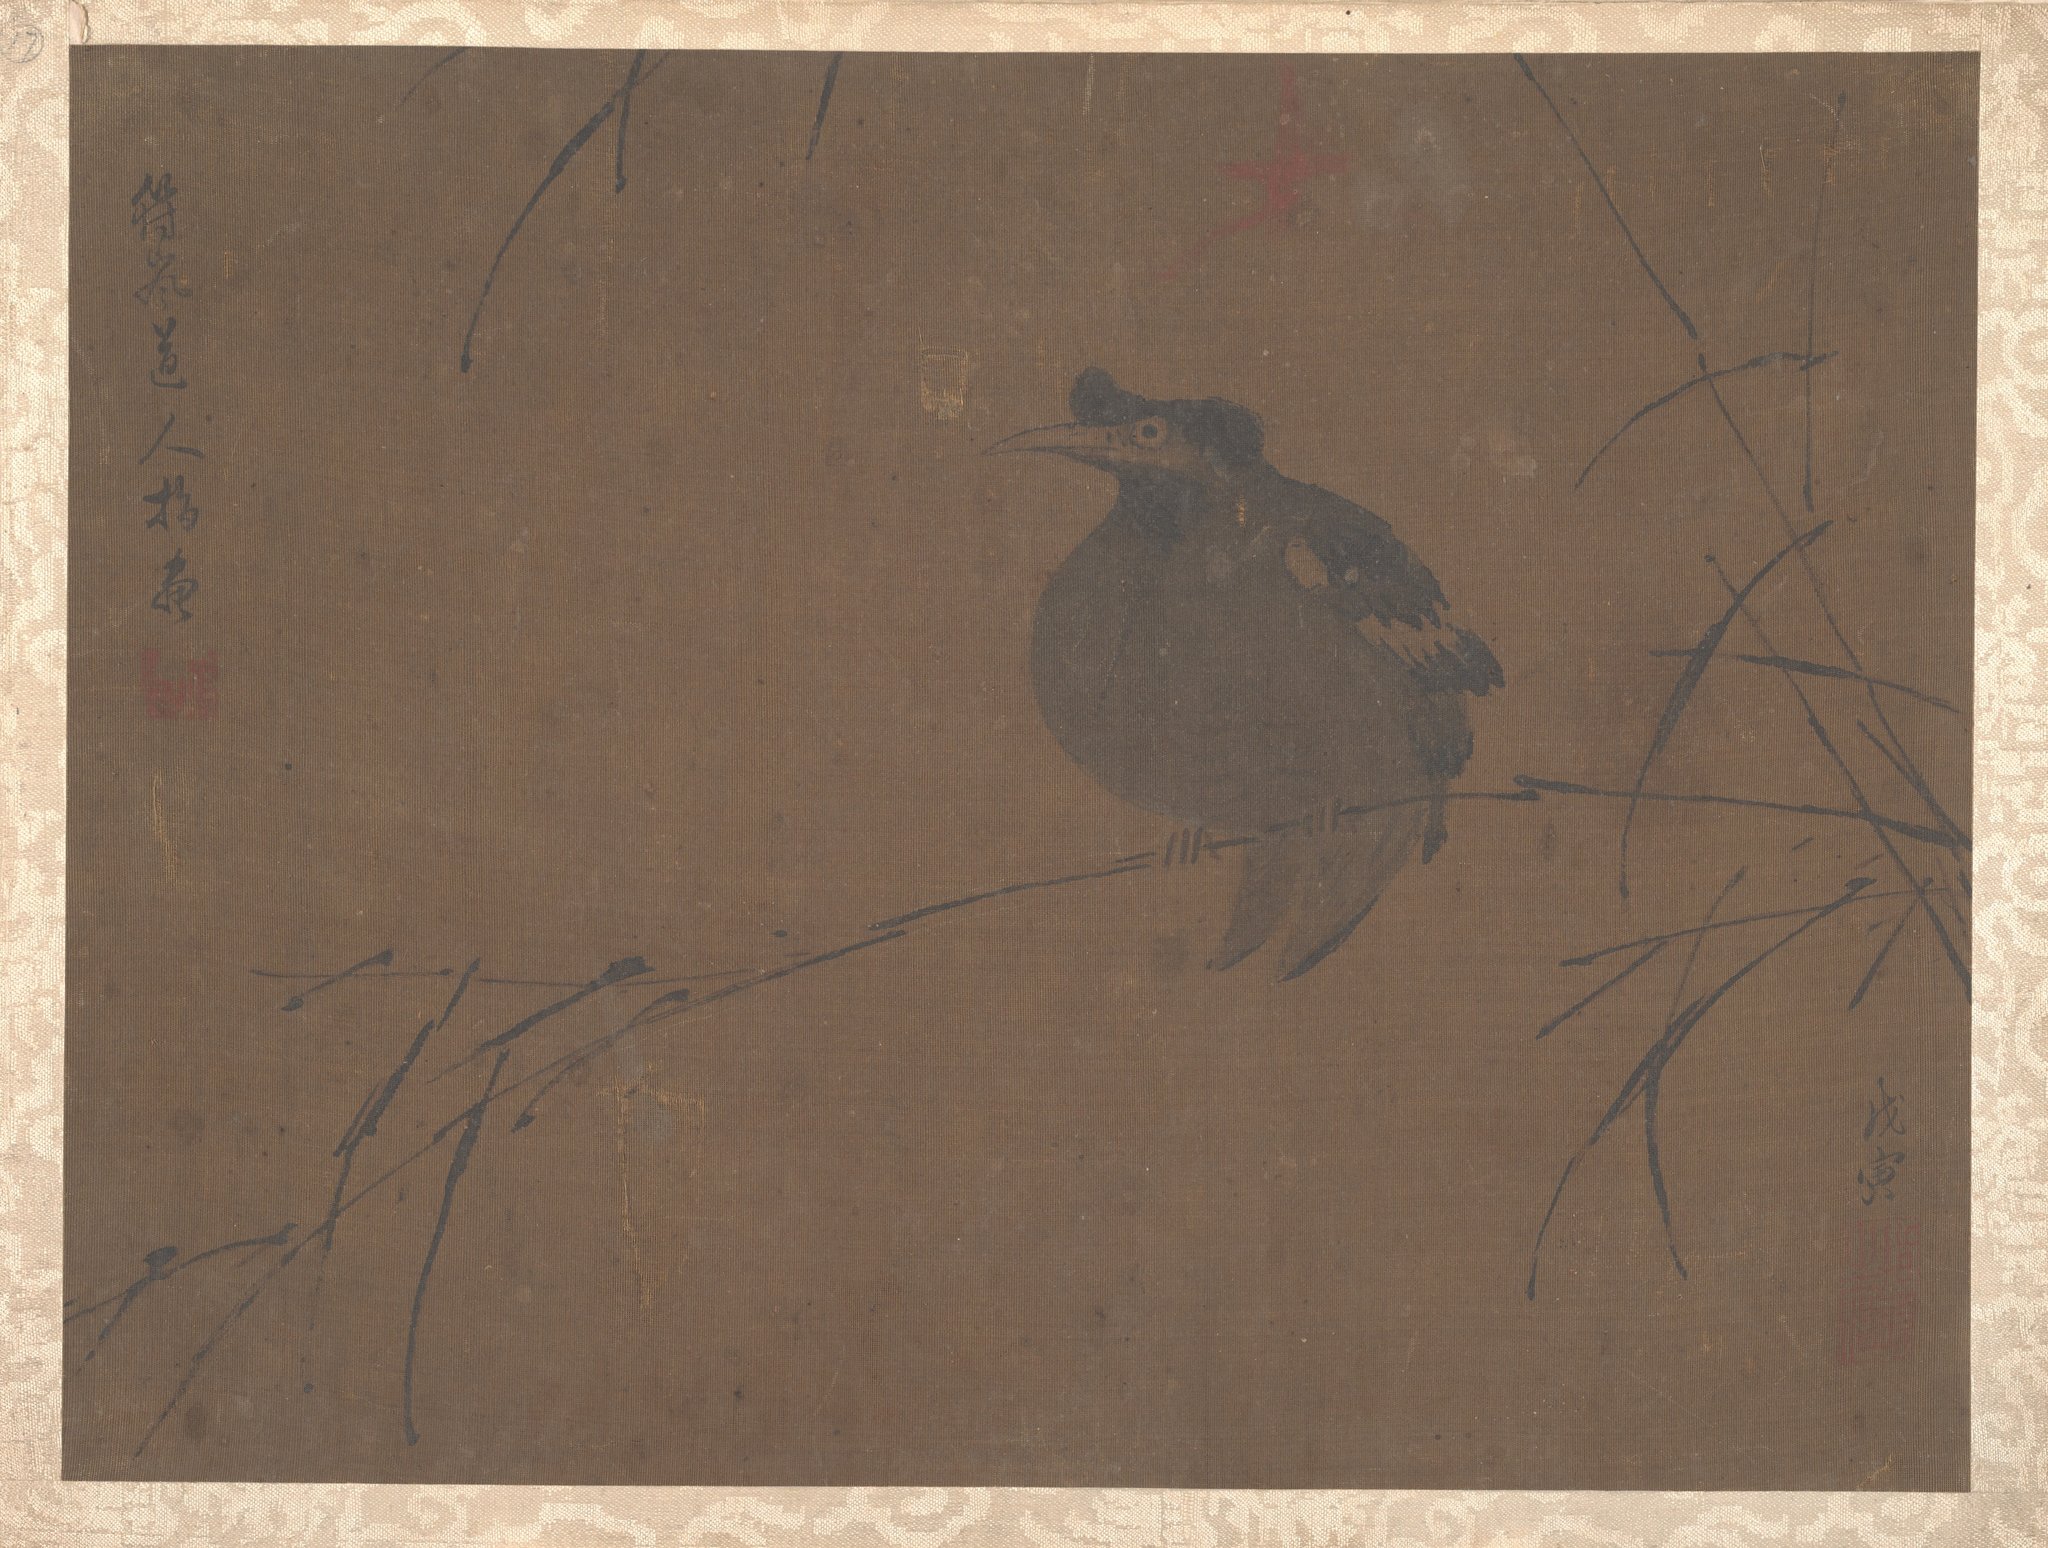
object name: album leaf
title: Mynah on Reed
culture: chinese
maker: fulan taorên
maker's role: artist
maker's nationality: chinese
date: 1368-1644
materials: ink, silk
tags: birds